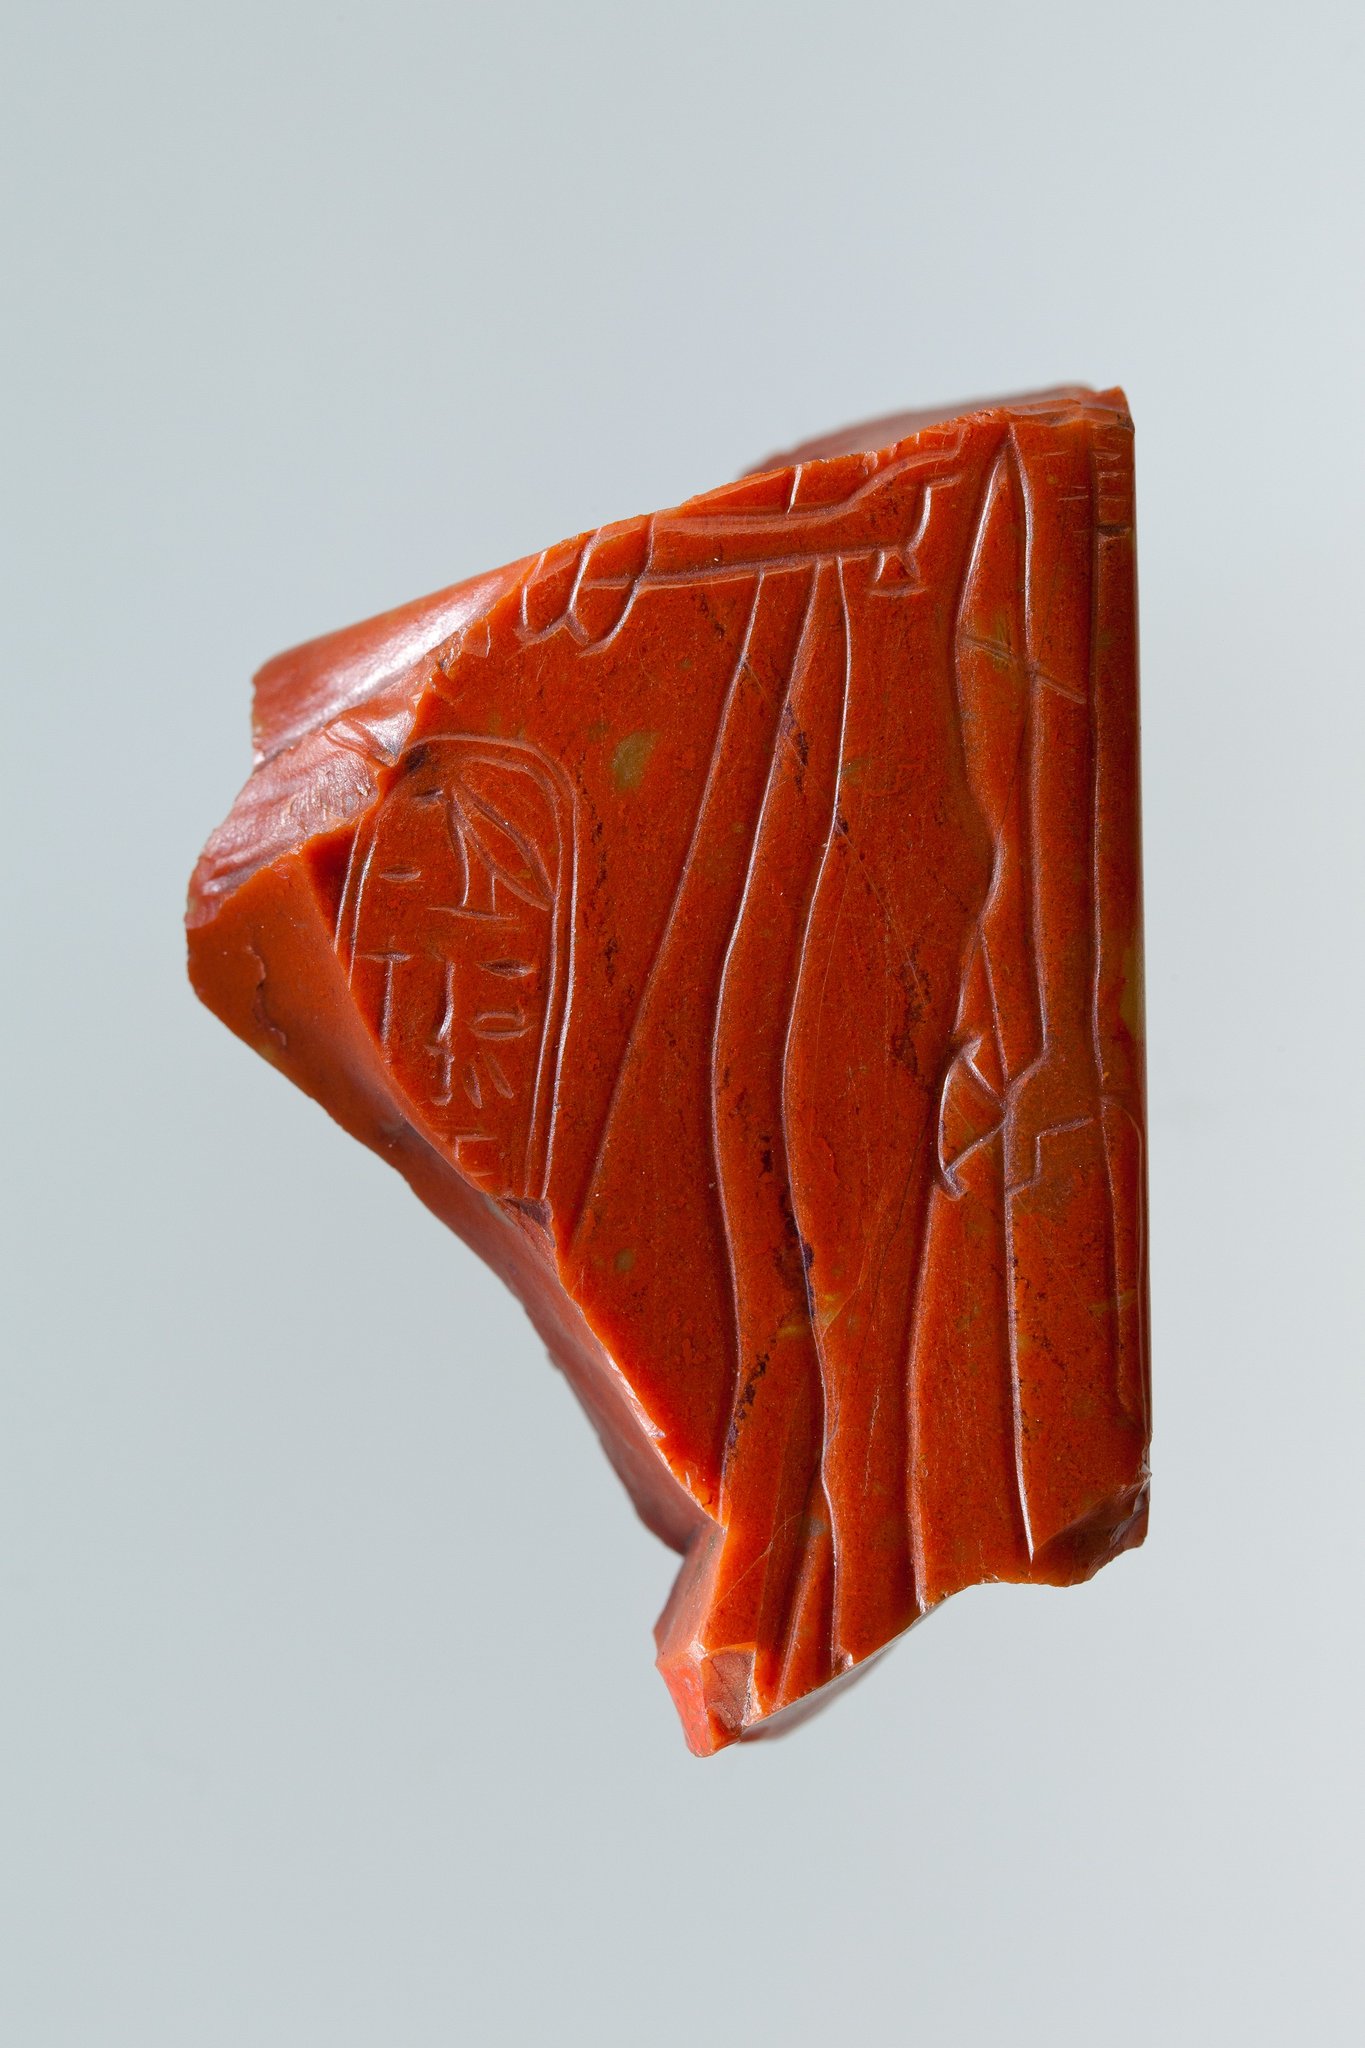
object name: statue fragment, ramesses ii cartouche, queen nefertari incised at side of leg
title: Statue fragment from a standing figure whose back pillar has cartouche of Ramesses II, and the figure of queen Nefertari incised on side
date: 1279-1213 BCE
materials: jasper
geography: egypt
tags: cartouches,hieroglyphs